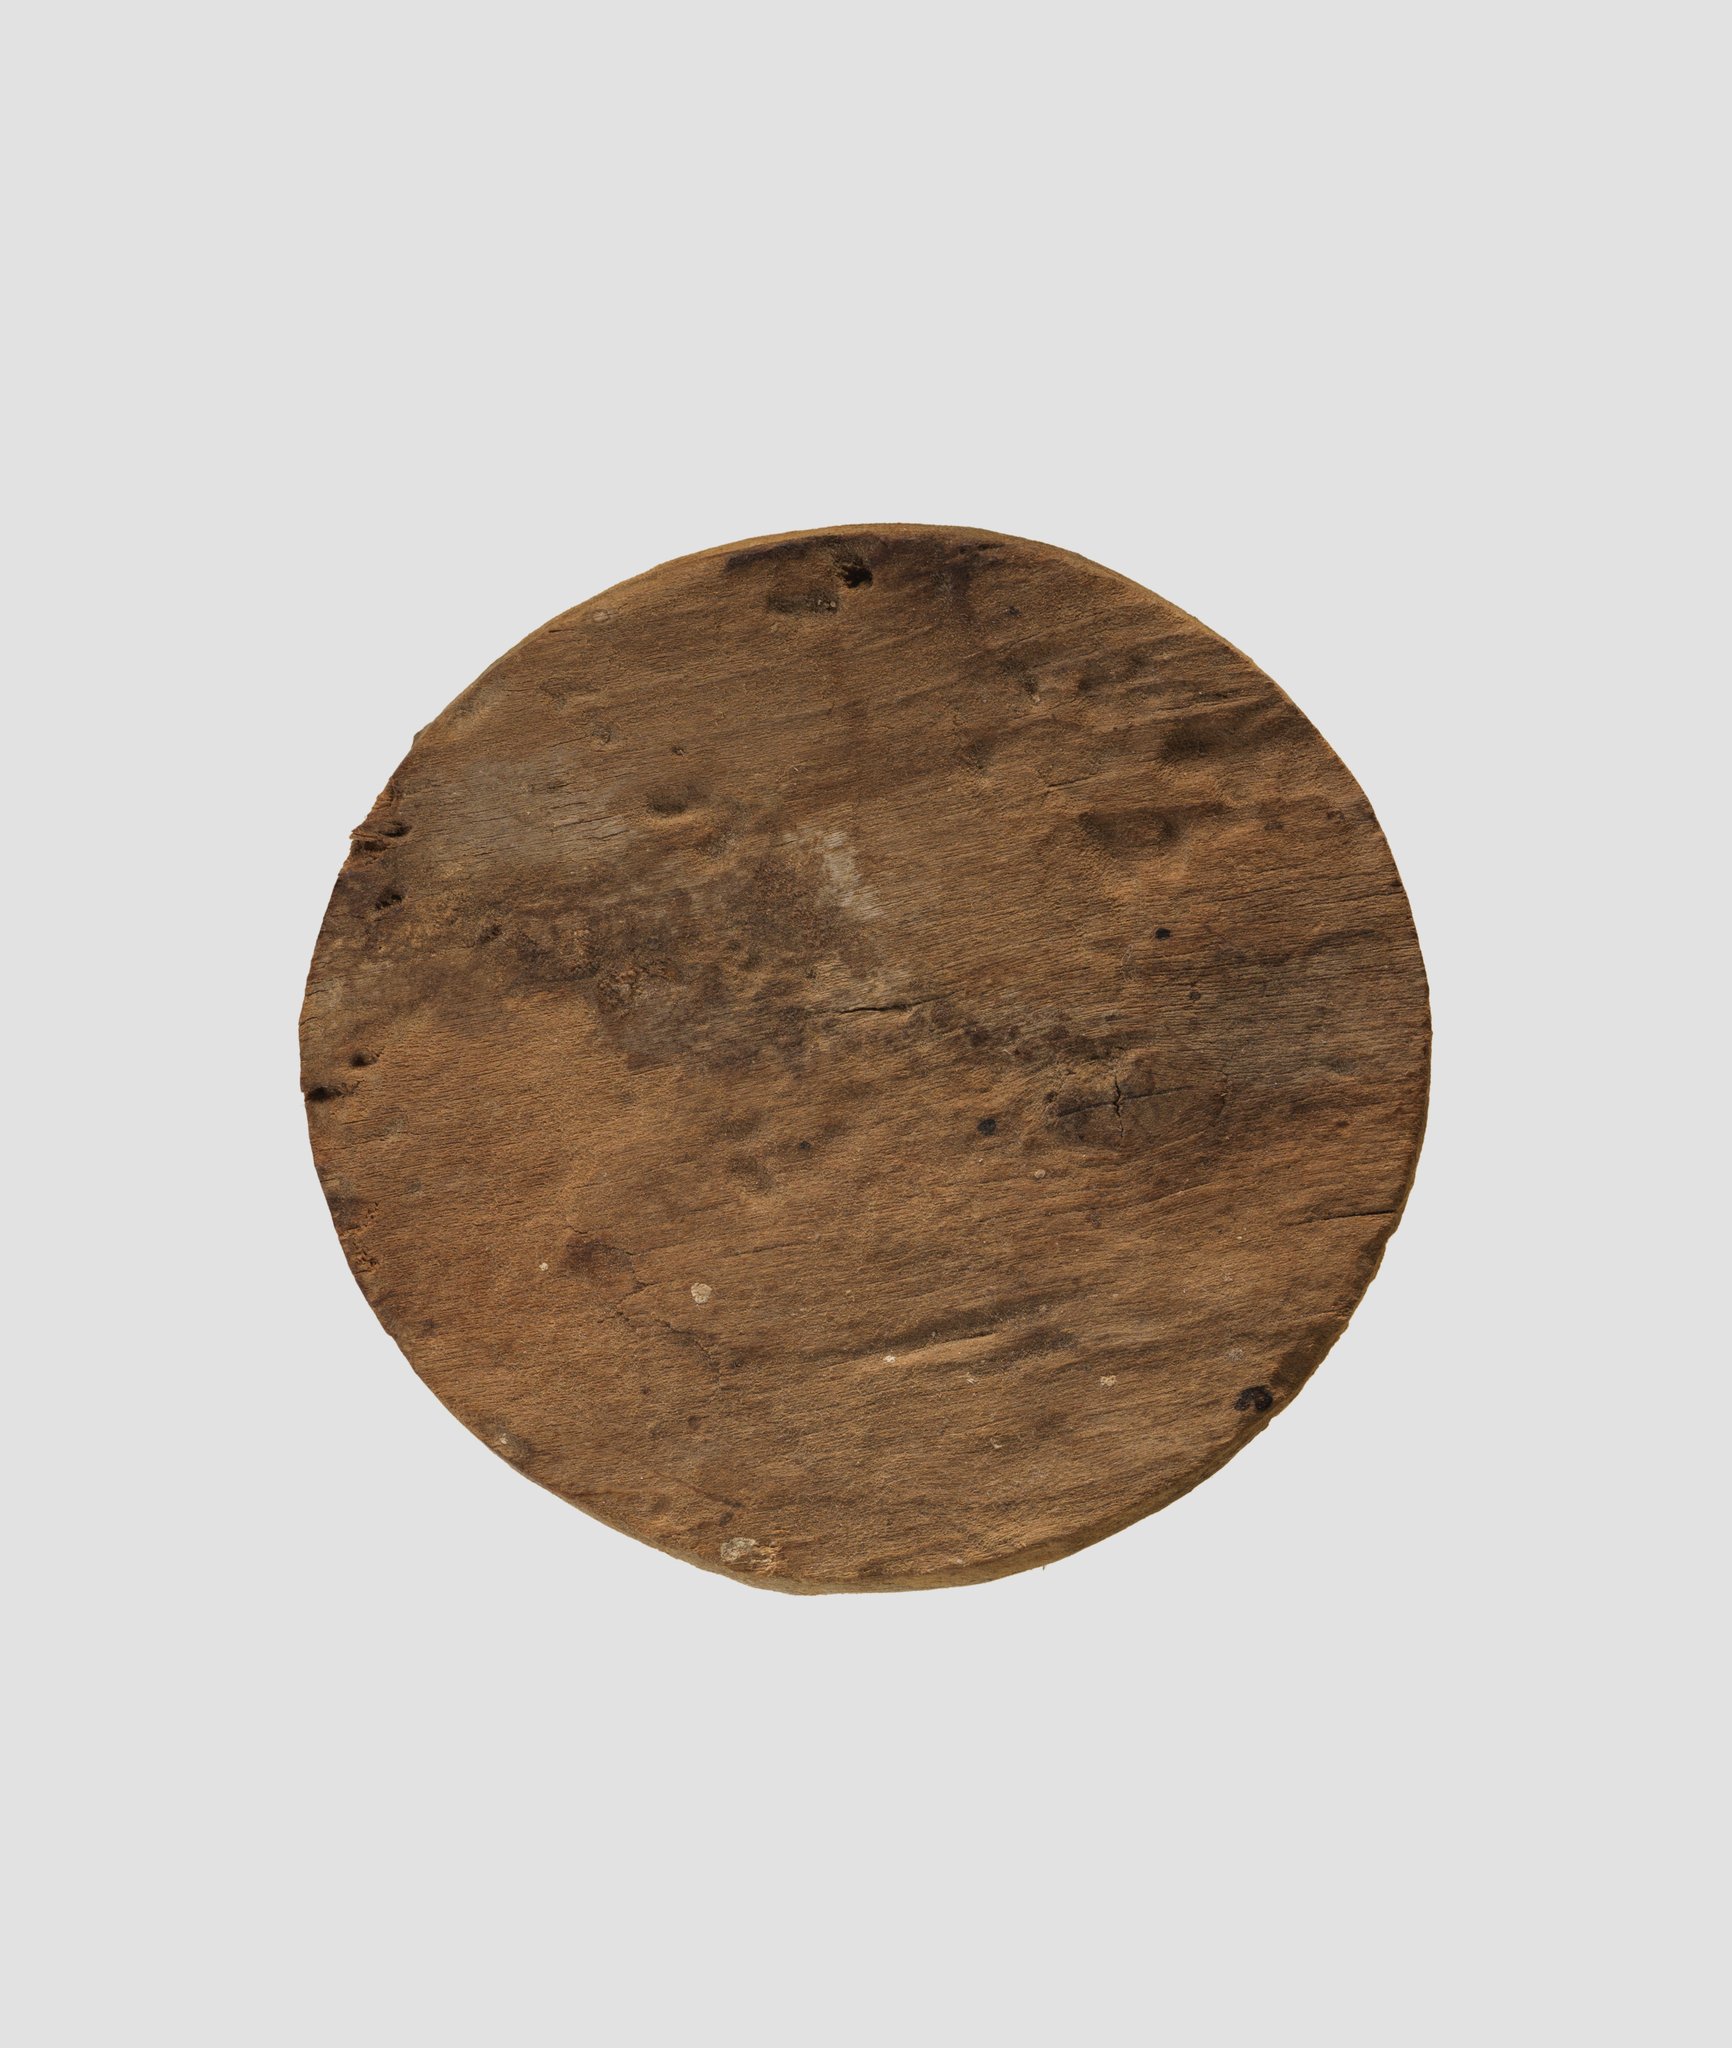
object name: disc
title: Wooden disc (part of a horn drinking cup)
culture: alanic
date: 601-900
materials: wood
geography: caucasus